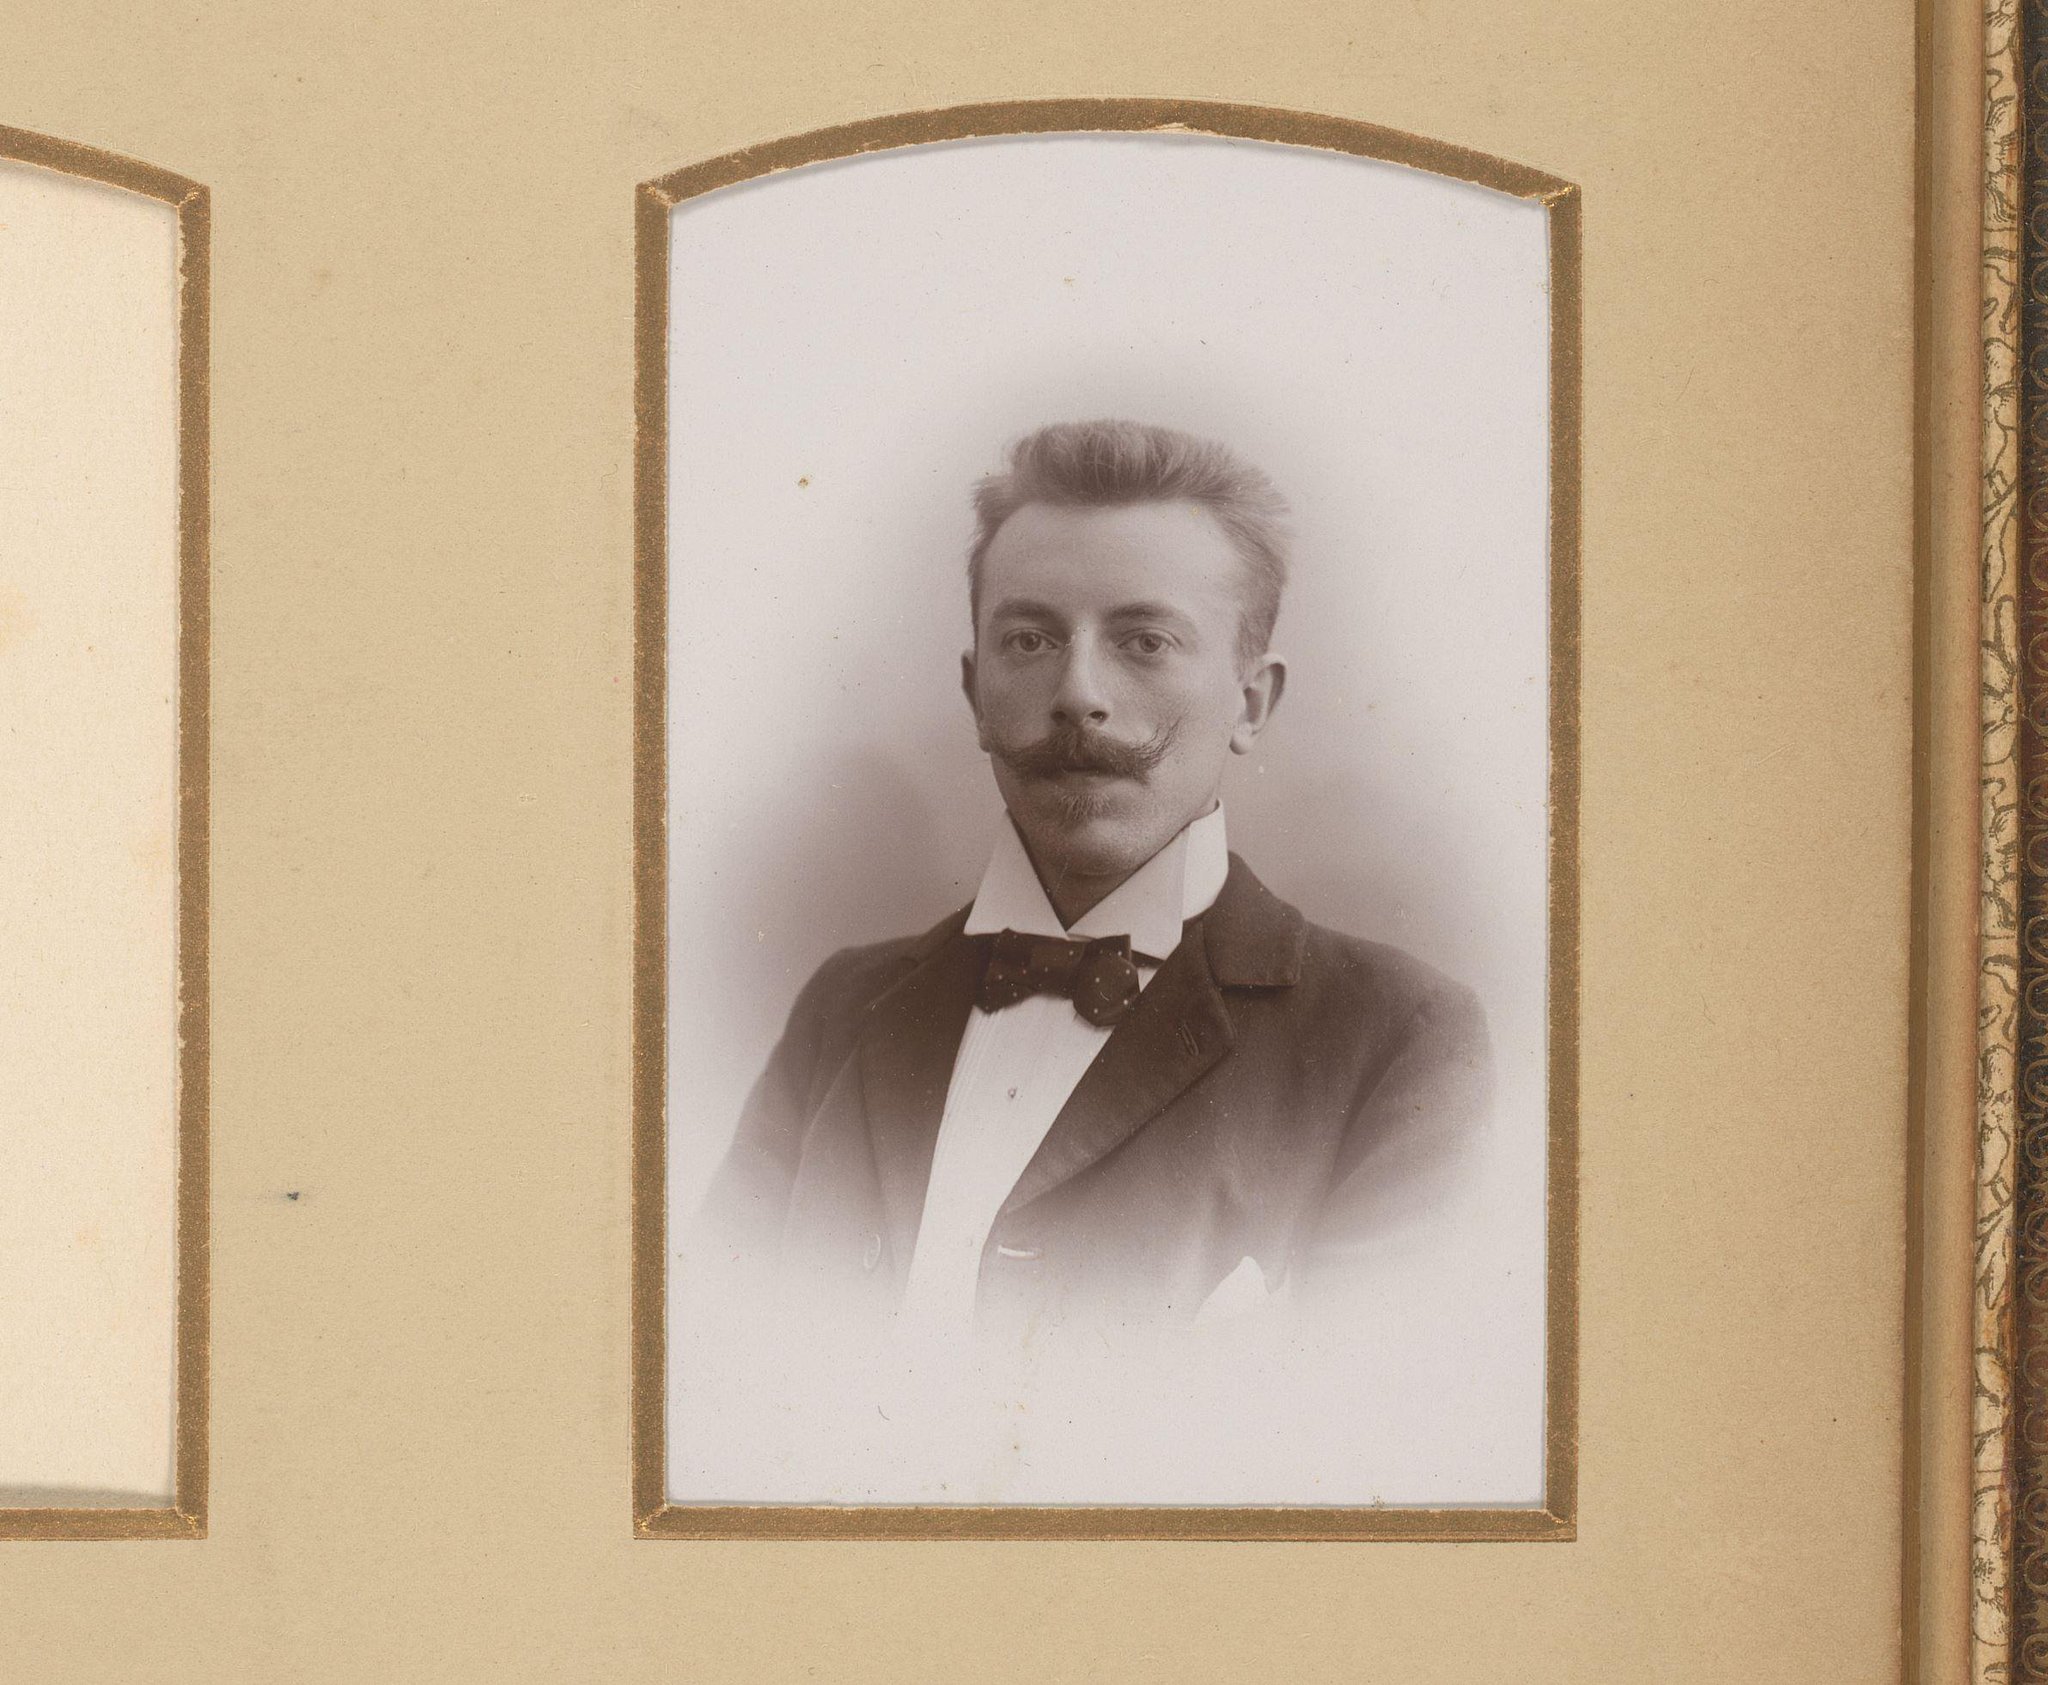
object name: album leaf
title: Portret van een man met snor en vlinderstrik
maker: machiel hendricus laddé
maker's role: fotograaf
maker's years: 1866-1932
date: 1892-1906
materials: cardboard, photographic support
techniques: collodion silver print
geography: amsterdam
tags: moustache, historical persons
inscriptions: inscription: ‘Fotografie/ Artistique/ M. H. Laddé/ Nieuwendijk 57-59/ boven de Firma MERKELBACH & Co./ Het Cliché wordt voor verdere bestellingen bewaard.’